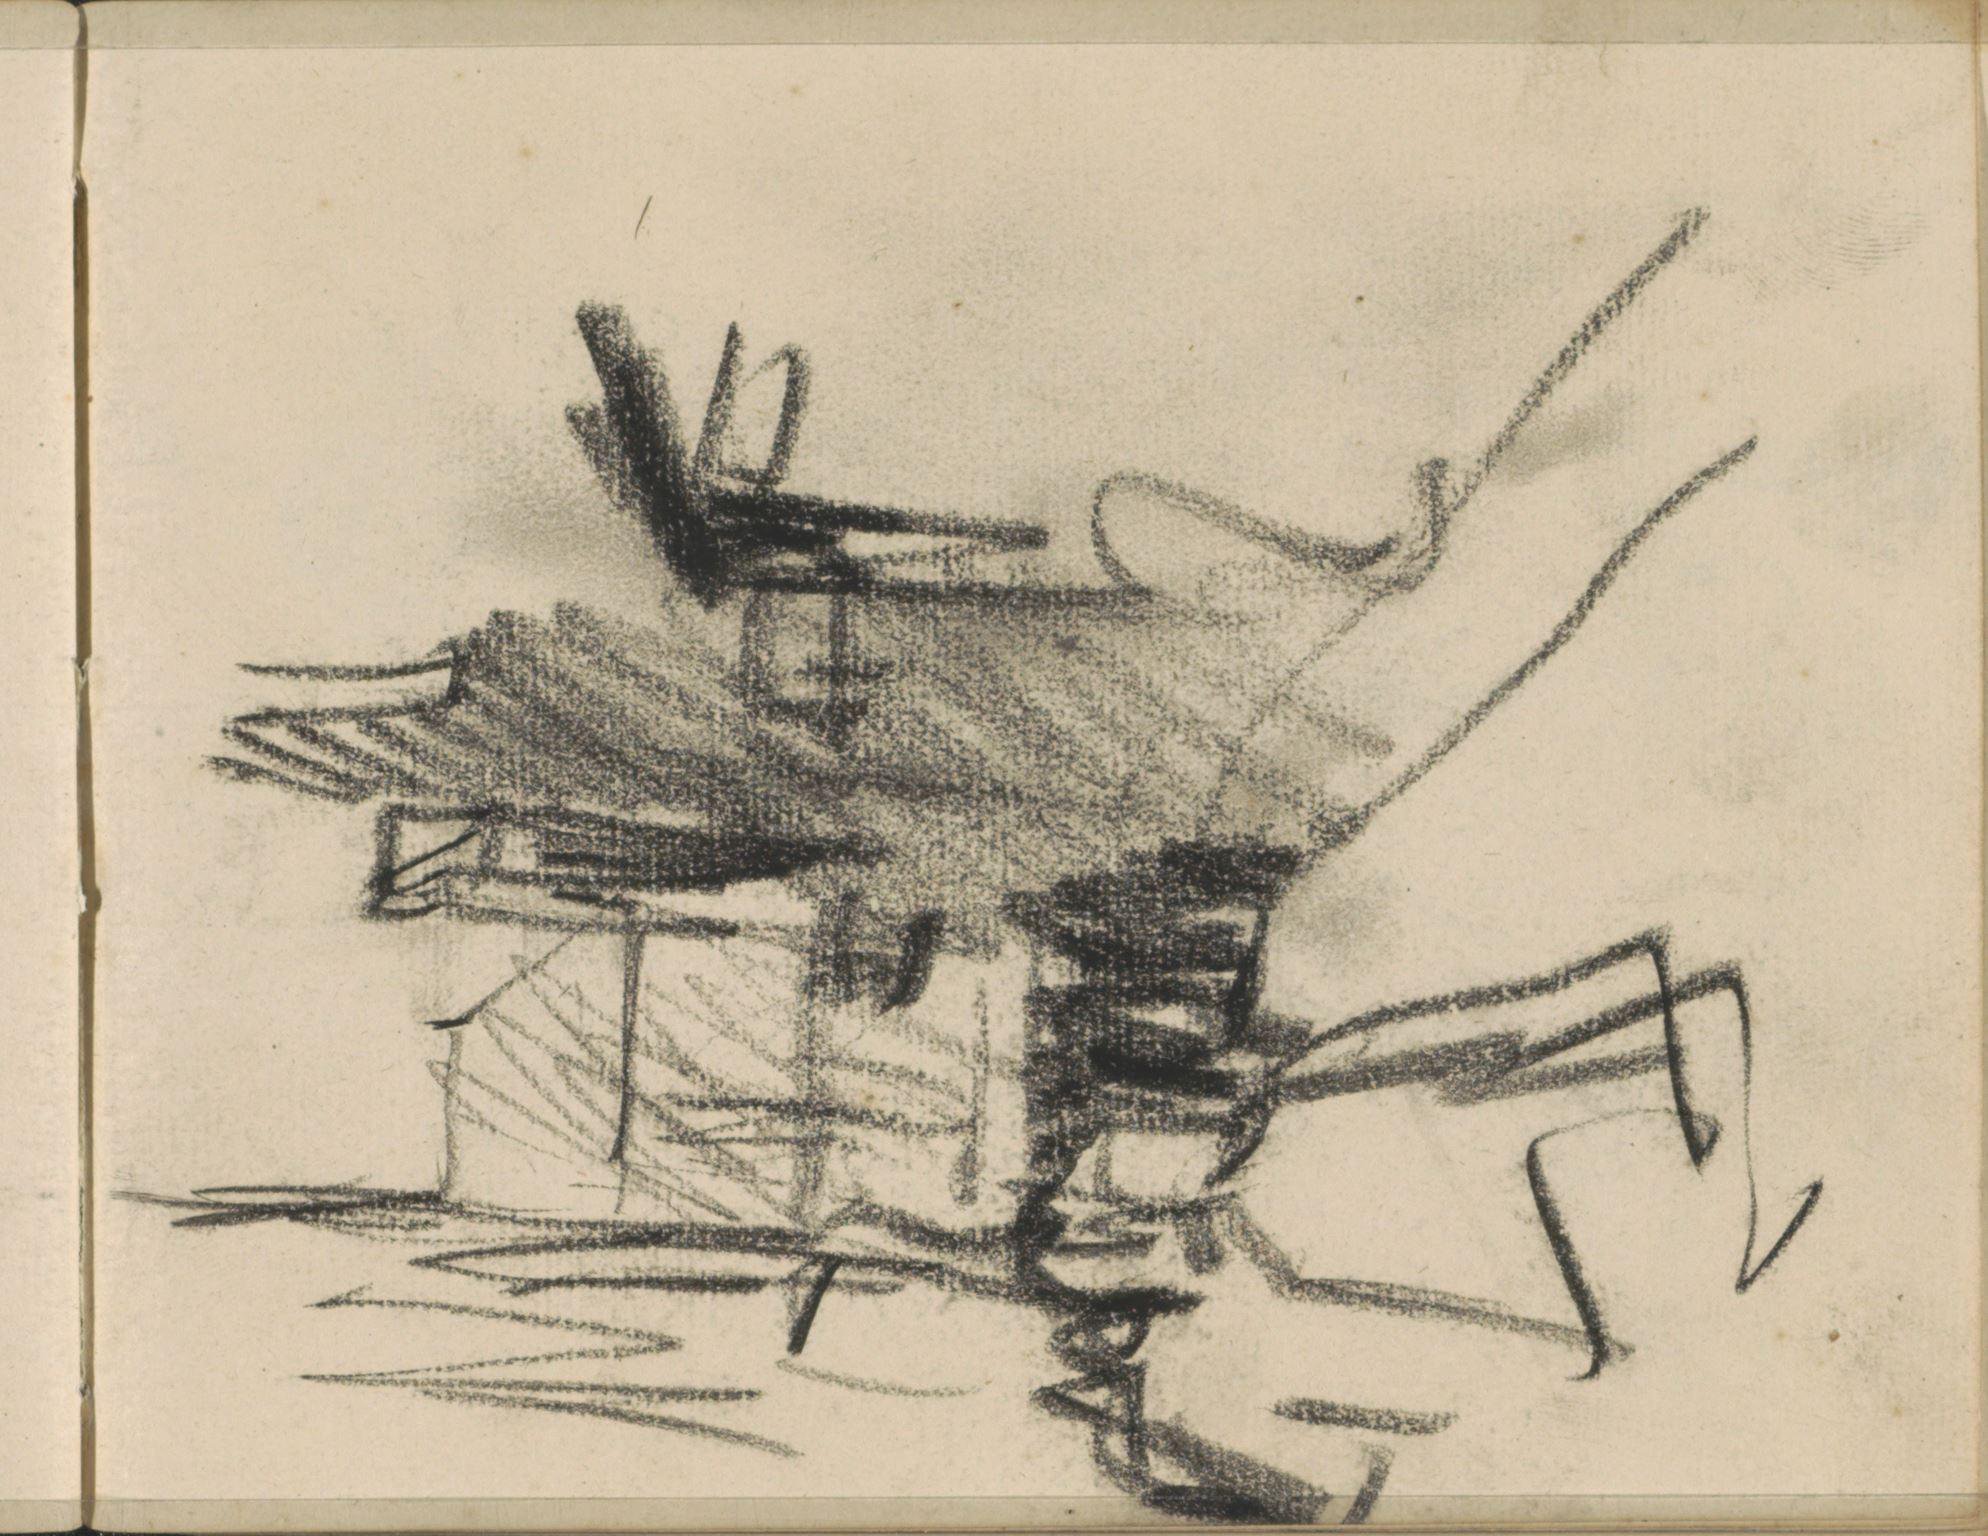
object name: sketchbook leaf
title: Kalverstraat te Amsterdam, gezien naar de Dam met de Nieuwe Kerk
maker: george hendrik breitner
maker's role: draughtsman, painter, print maker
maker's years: 1857-1923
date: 1886-1903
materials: chalk, paper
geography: amsterdam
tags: church (exterior), street (+ city(-scape) with figures, staffage)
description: Pagina 20 uit een schetsboek met 27 bladen.